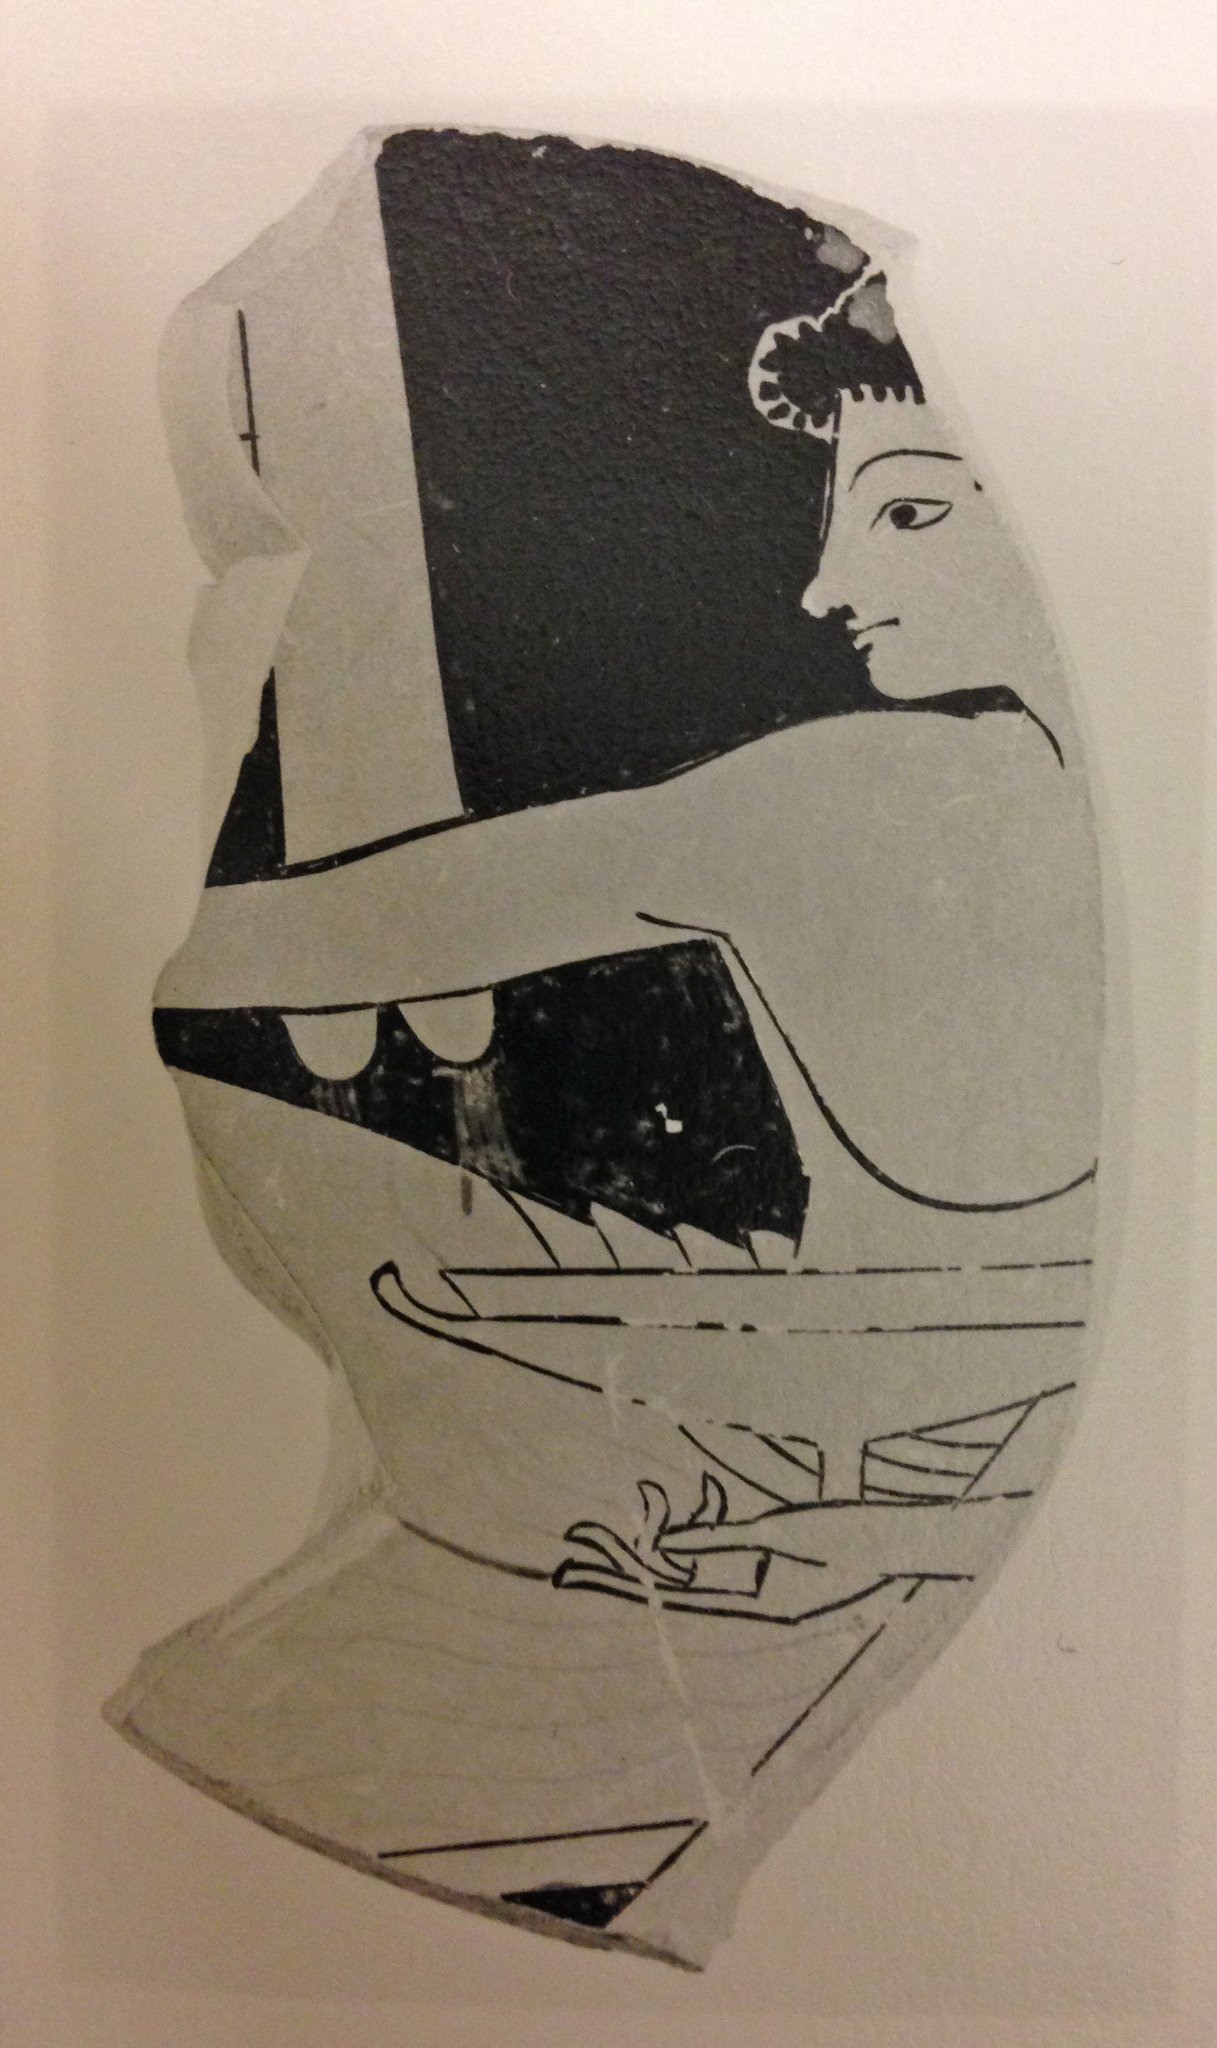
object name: kylix fragment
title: Fragment of a terracotta kylix (drinking cup)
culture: greek, attic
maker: euphronios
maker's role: artist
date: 520-510 BCE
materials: terracotta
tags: human figures